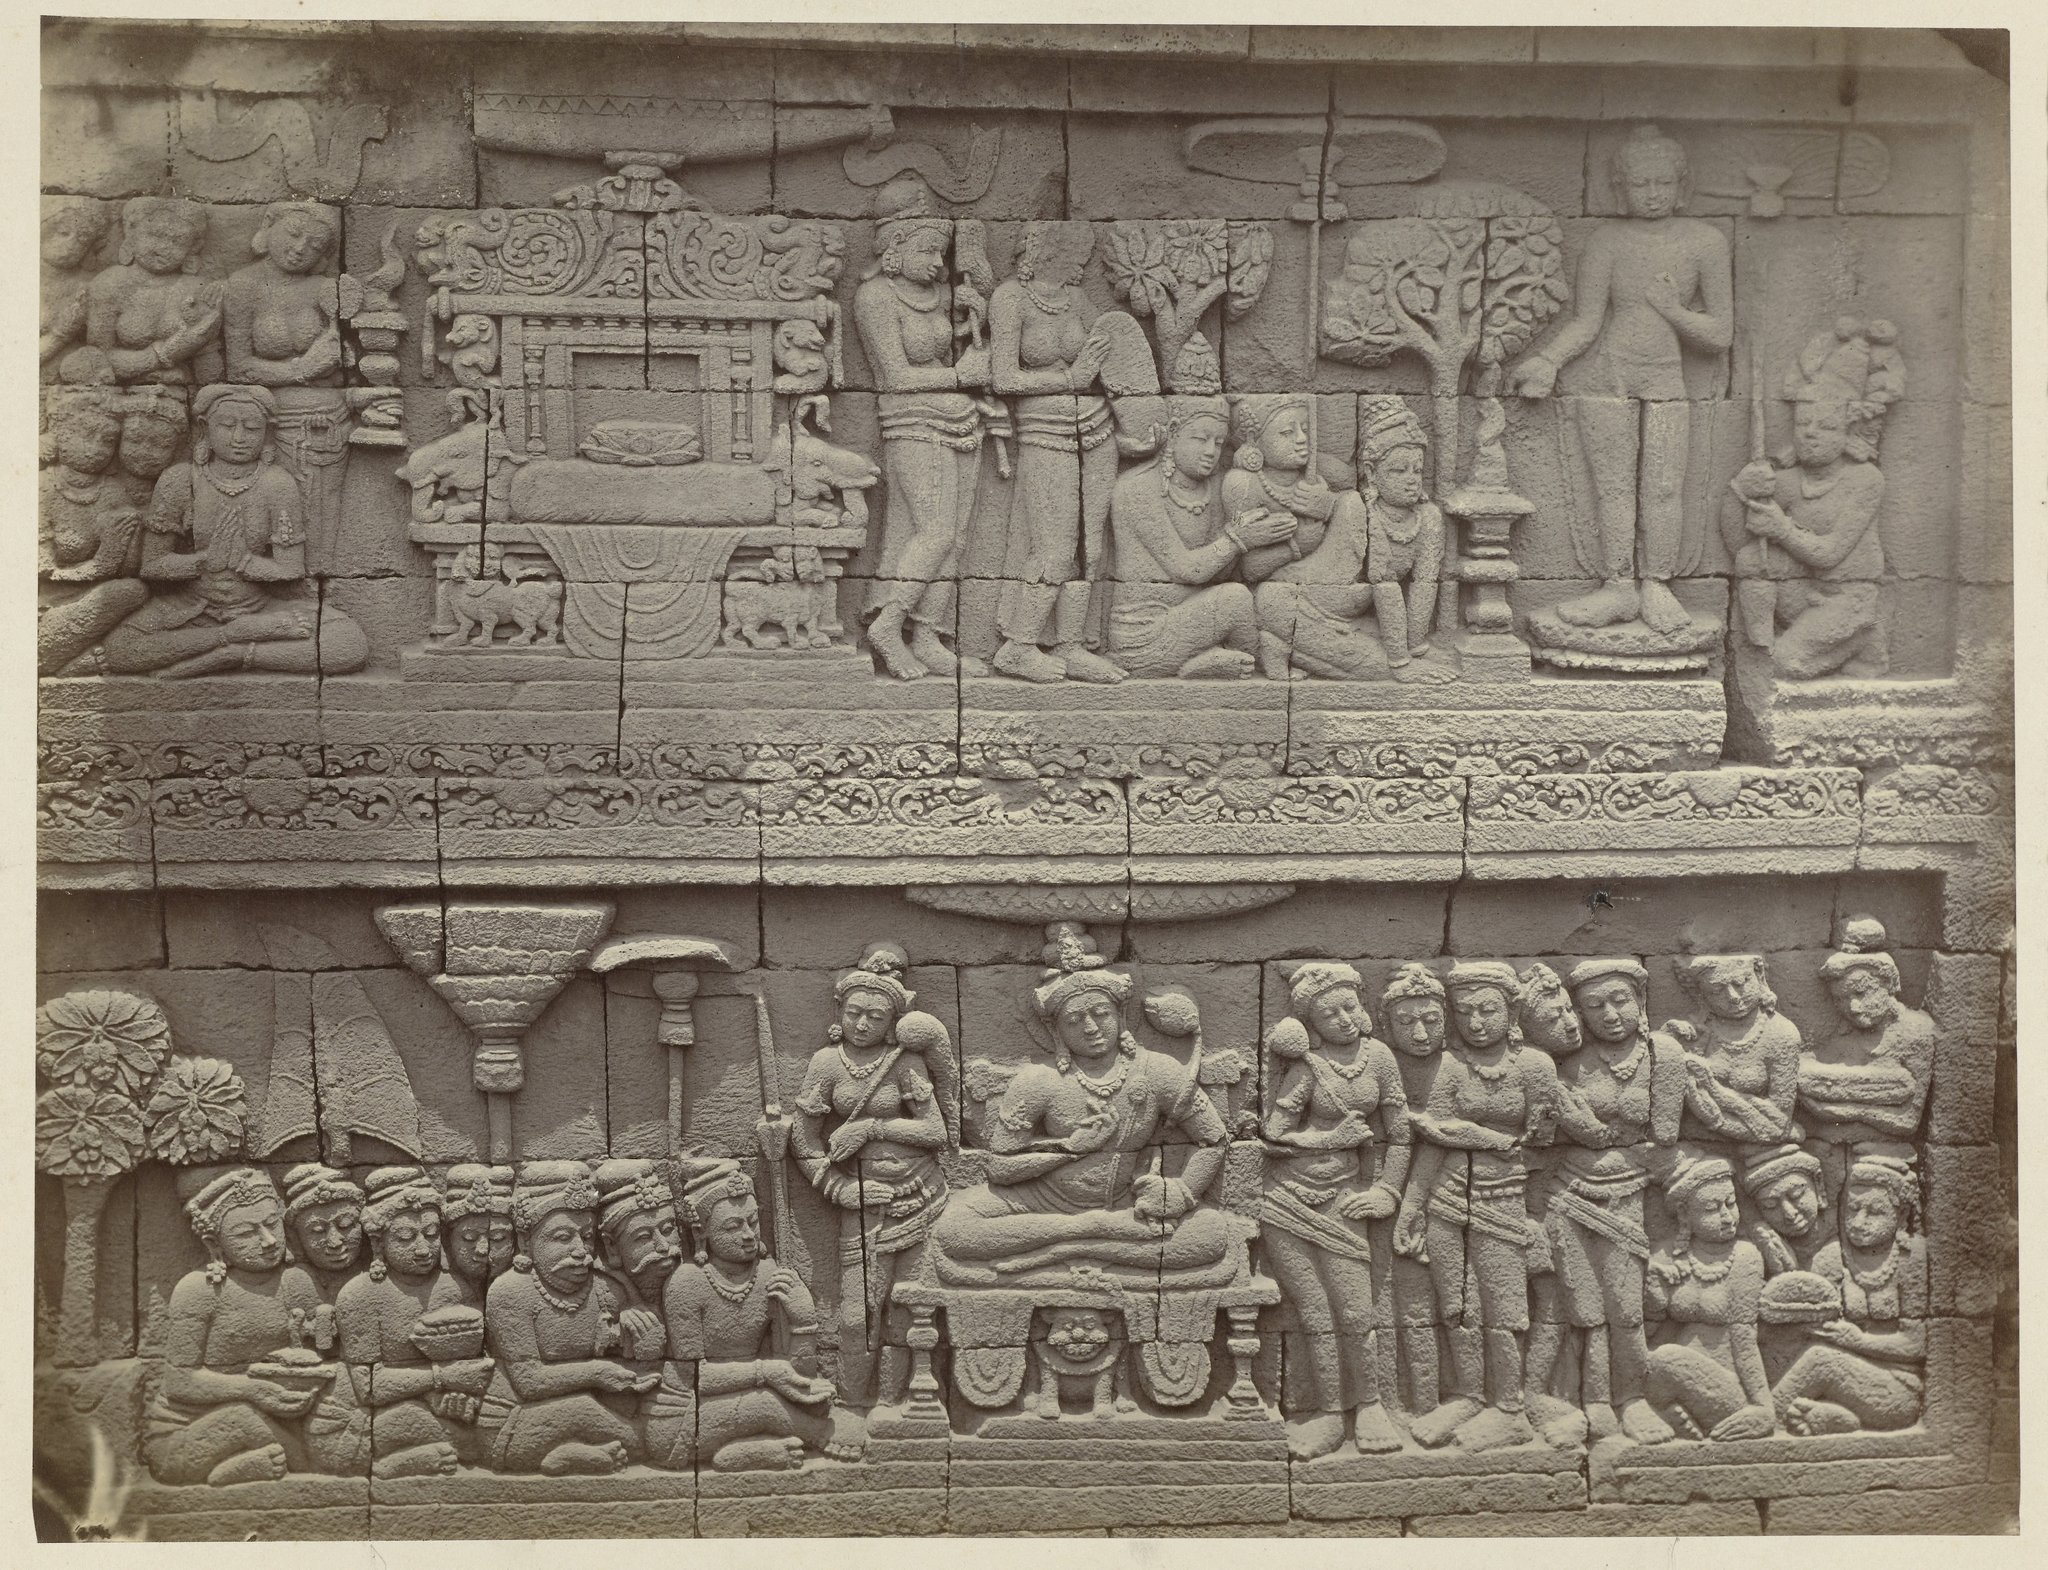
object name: photograph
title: Basreliëf in de muur aan de oostzijde van de Borobudur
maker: isidore kinsbergen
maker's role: fotograaf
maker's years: 1821-1905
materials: cardboard, paper, photographic support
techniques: albumen print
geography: java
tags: borobudur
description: Gallery I, main wall, east side 59 (top): Relief 1a-113, Lalitavistara relief, the Buddha is invited to take his place on a throne. 60 (bottom): relief 1b-113, unidentified scene. Borobudur village, Magelang district, Central Java province, 778-824 AD.